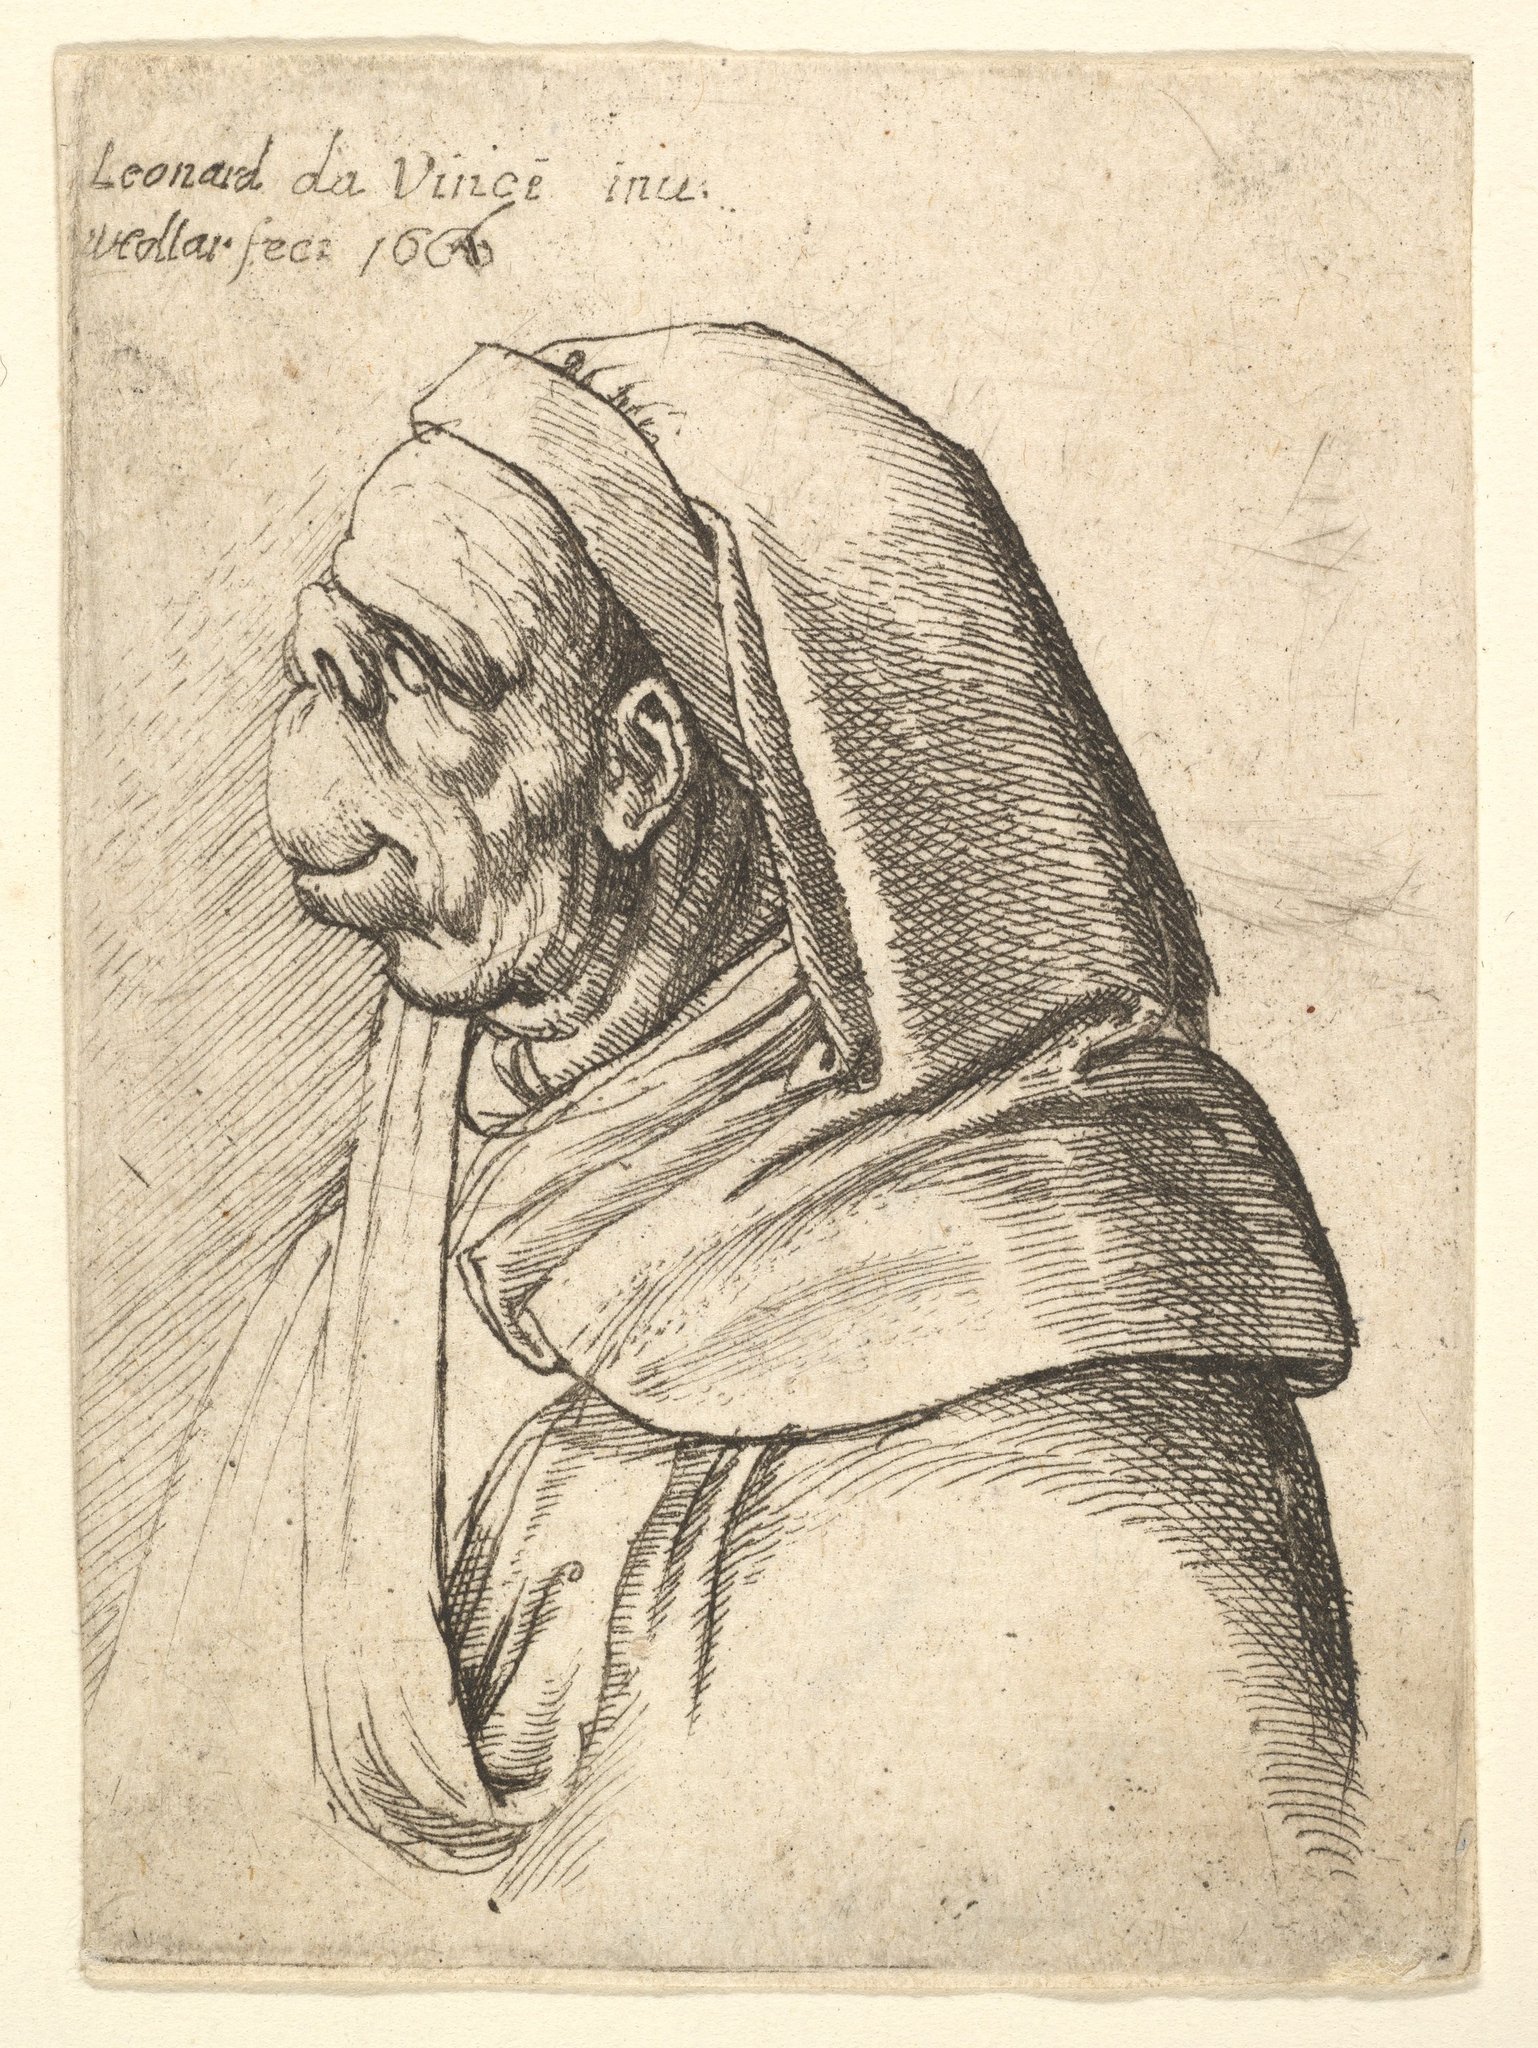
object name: print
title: Bust of a man with a small turned-up nose and very high upper lip, wearing hood, in profile to the left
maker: wenceslaus hollar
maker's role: artist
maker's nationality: bohemian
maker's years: 1607-1677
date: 1666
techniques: etching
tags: men